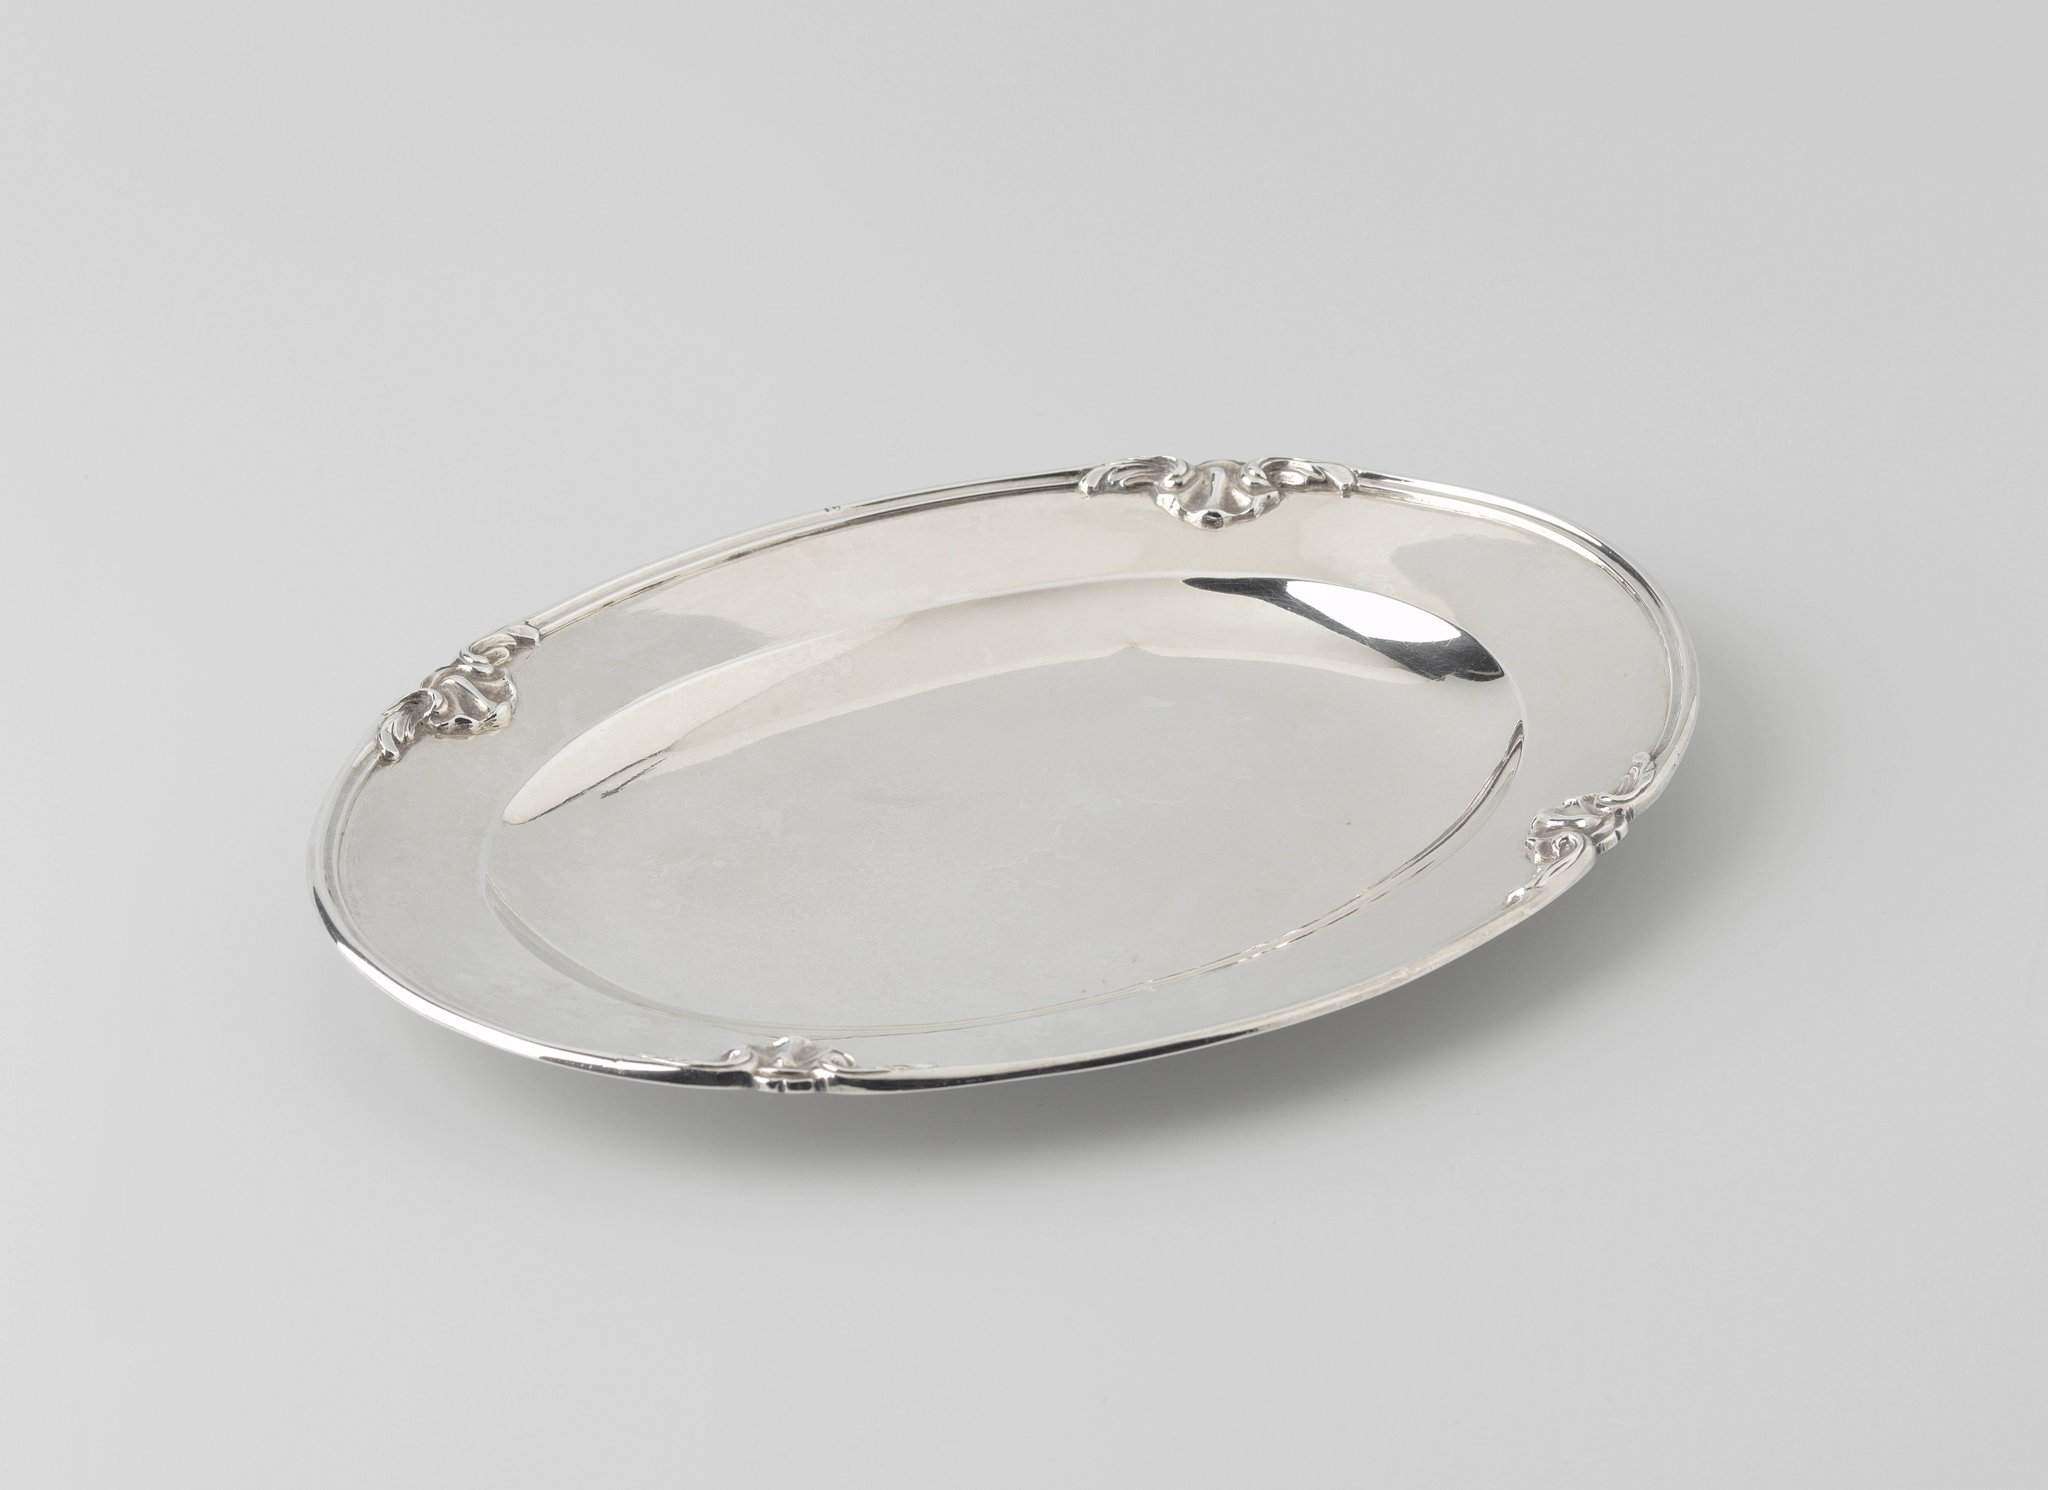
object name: platter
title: Ovale onderschotel van zilver voor sauskom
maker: valentijn caspar bömcke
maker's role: silversmith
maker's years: 1726-1782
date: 1764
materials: silver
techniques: casting, hammering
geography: amsterdam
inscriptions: town mark, duty mark, date letter: ‘E’, alloy mark, maker's mark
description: Ovale onderschotel voor sauskom. De schotel heeft een verdiept blad. De rand is versierd met een profiel, dat op vier plaatsen wordt onderbroken door een schelpmotief. De schotel is gemerkt.